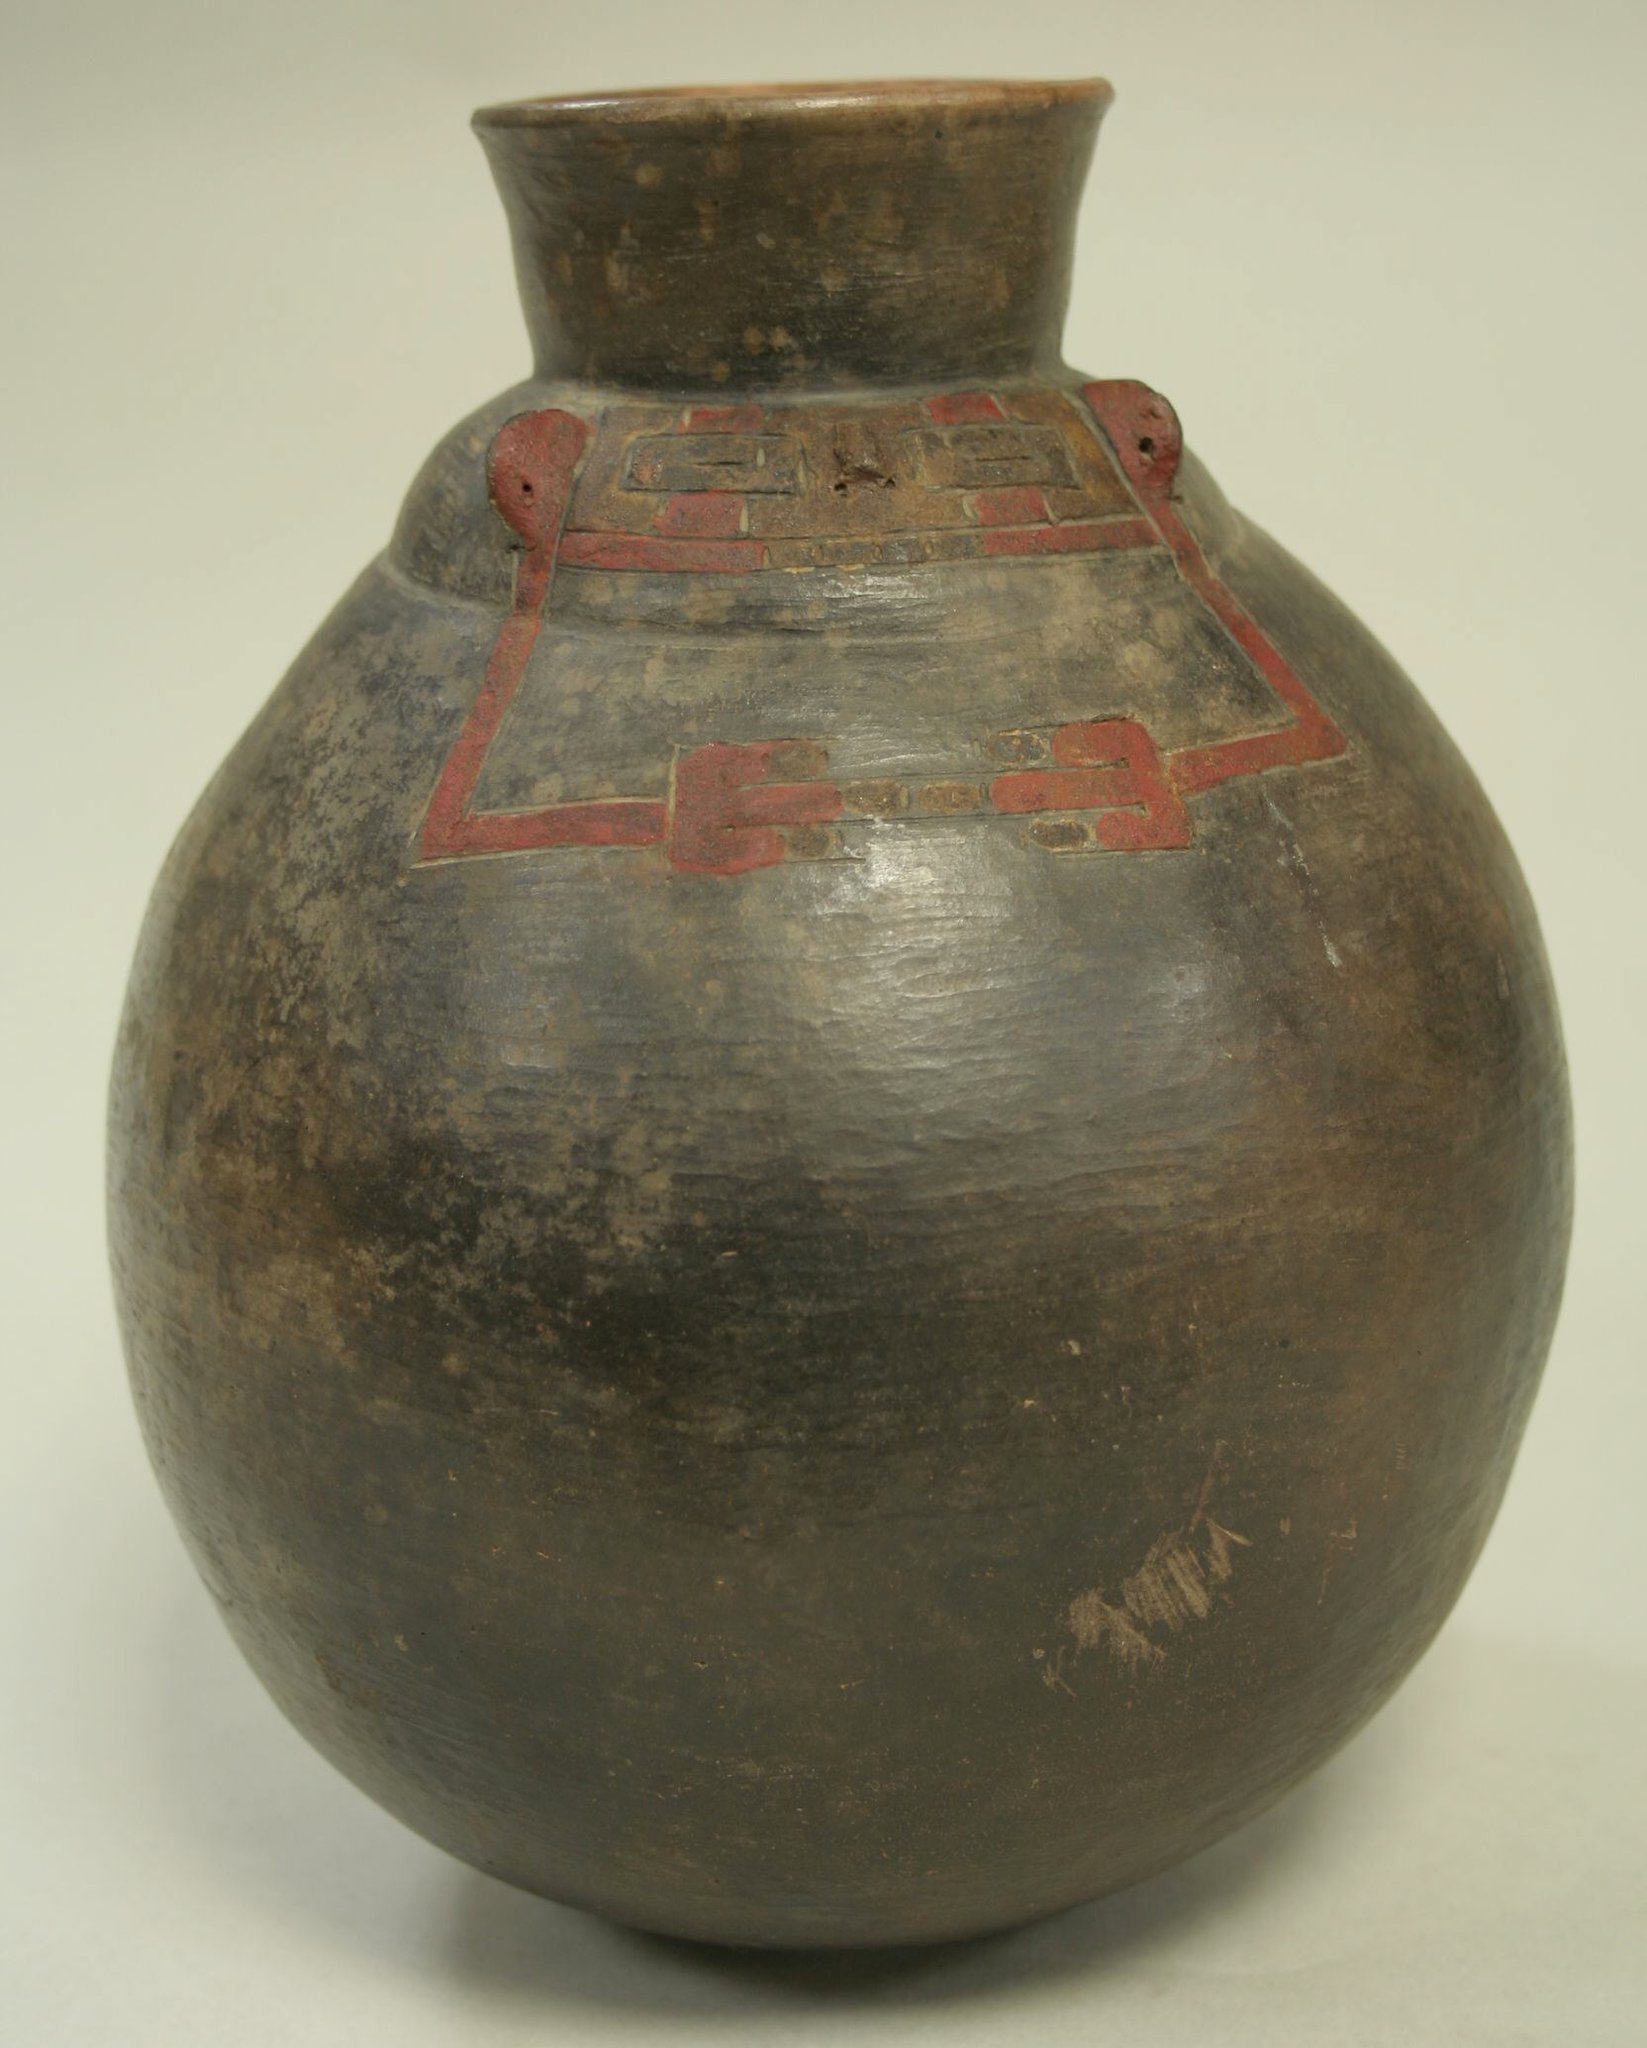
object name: bottle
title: Bottle, Face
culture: paracas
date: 700-301 BCE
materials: ceramic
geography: peru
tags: faces